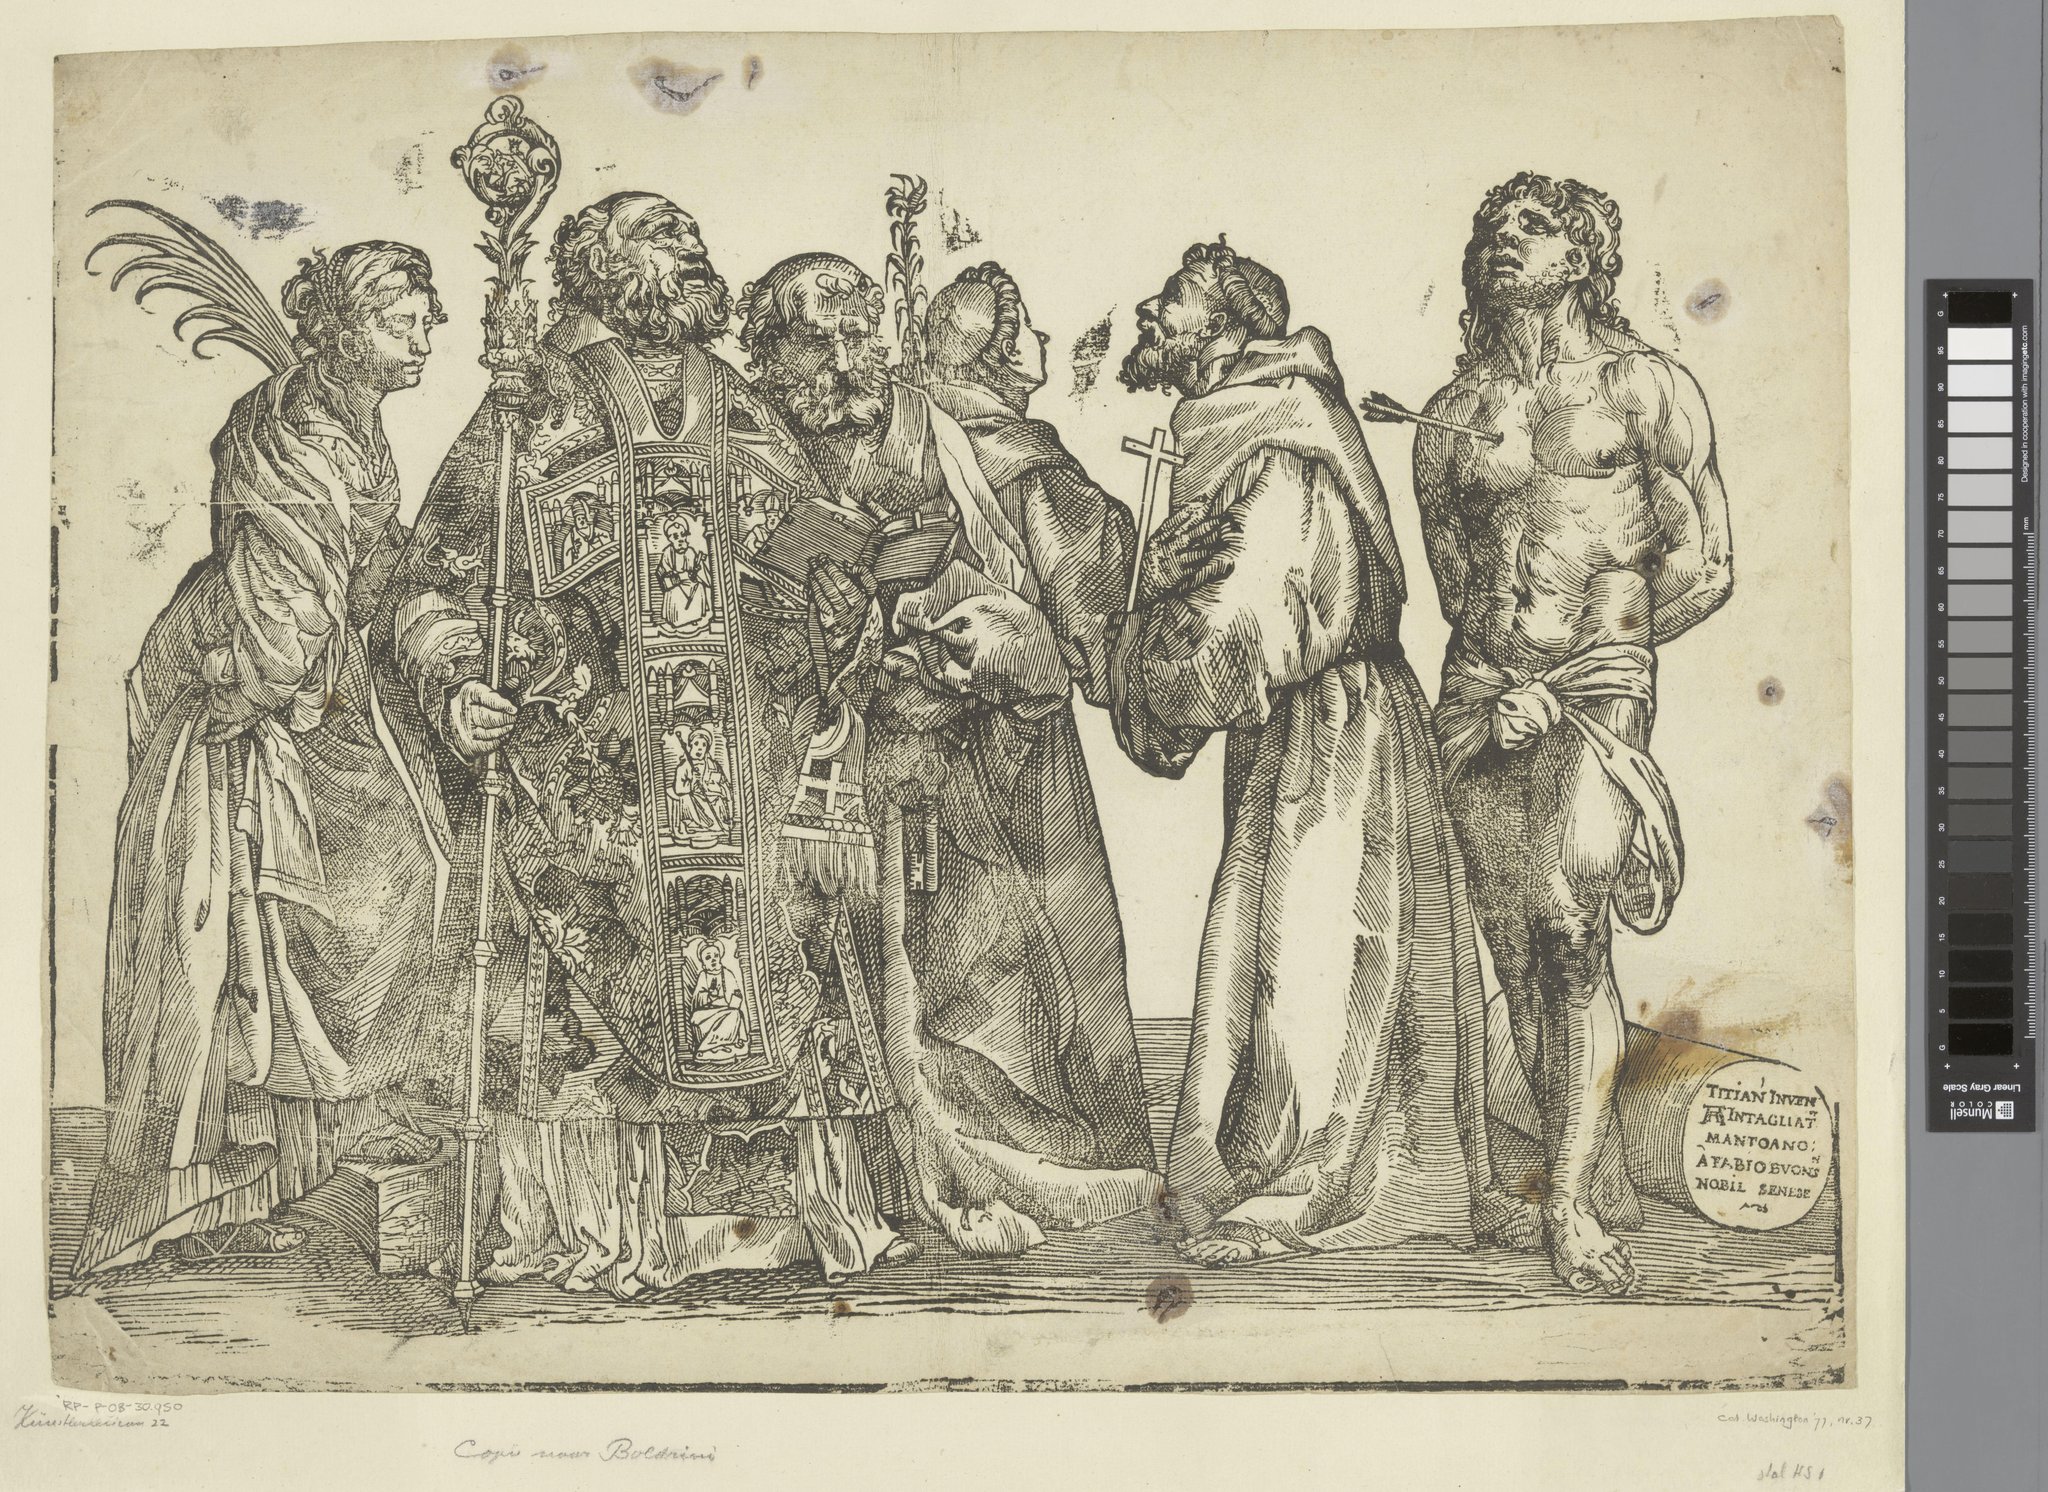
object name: print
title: Zes staande heiligen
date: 1586-1598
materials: paper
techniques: woodcut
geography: italy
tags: the virgin martyr catherine of alexandria; possible attributes: book, crown, emperor maxentius, palm-branch, ring, sword, wheel, the bishop nicholas of myra (or bari); possible attributes: anchor, boat, three golden balls (on a book), three purses, three children in a tub, three maidens, the martyr sebastian; possible attributes: arrow(s), bow, tree-trunk, founder of the order of friars minor (franciscans), francis(cus) of assisi; possible attributes: book, crucifix, lily, skull, stigmata, the apostle peter, first bishop of rome; possible attributes: book, cock, (upturned) cross, (triple) crozier, fish, key, scroll, ship, tiara, the franciscan monk antony of padua; possible attributes: ass, book, crucifix, flowered cross, flaming heart, infant christ (on book), lily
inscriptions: collector's mark: Lugt 240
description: Zes heiligen, staand naast elkaar: Catharina met palmtak van het martelaarschap, Nicolaas van Myra met boek en kromstaf, Petrus met sleutel, Antonius met lelie, Franciscus met kruis en Sebastiaan met pijl in zijn borst.